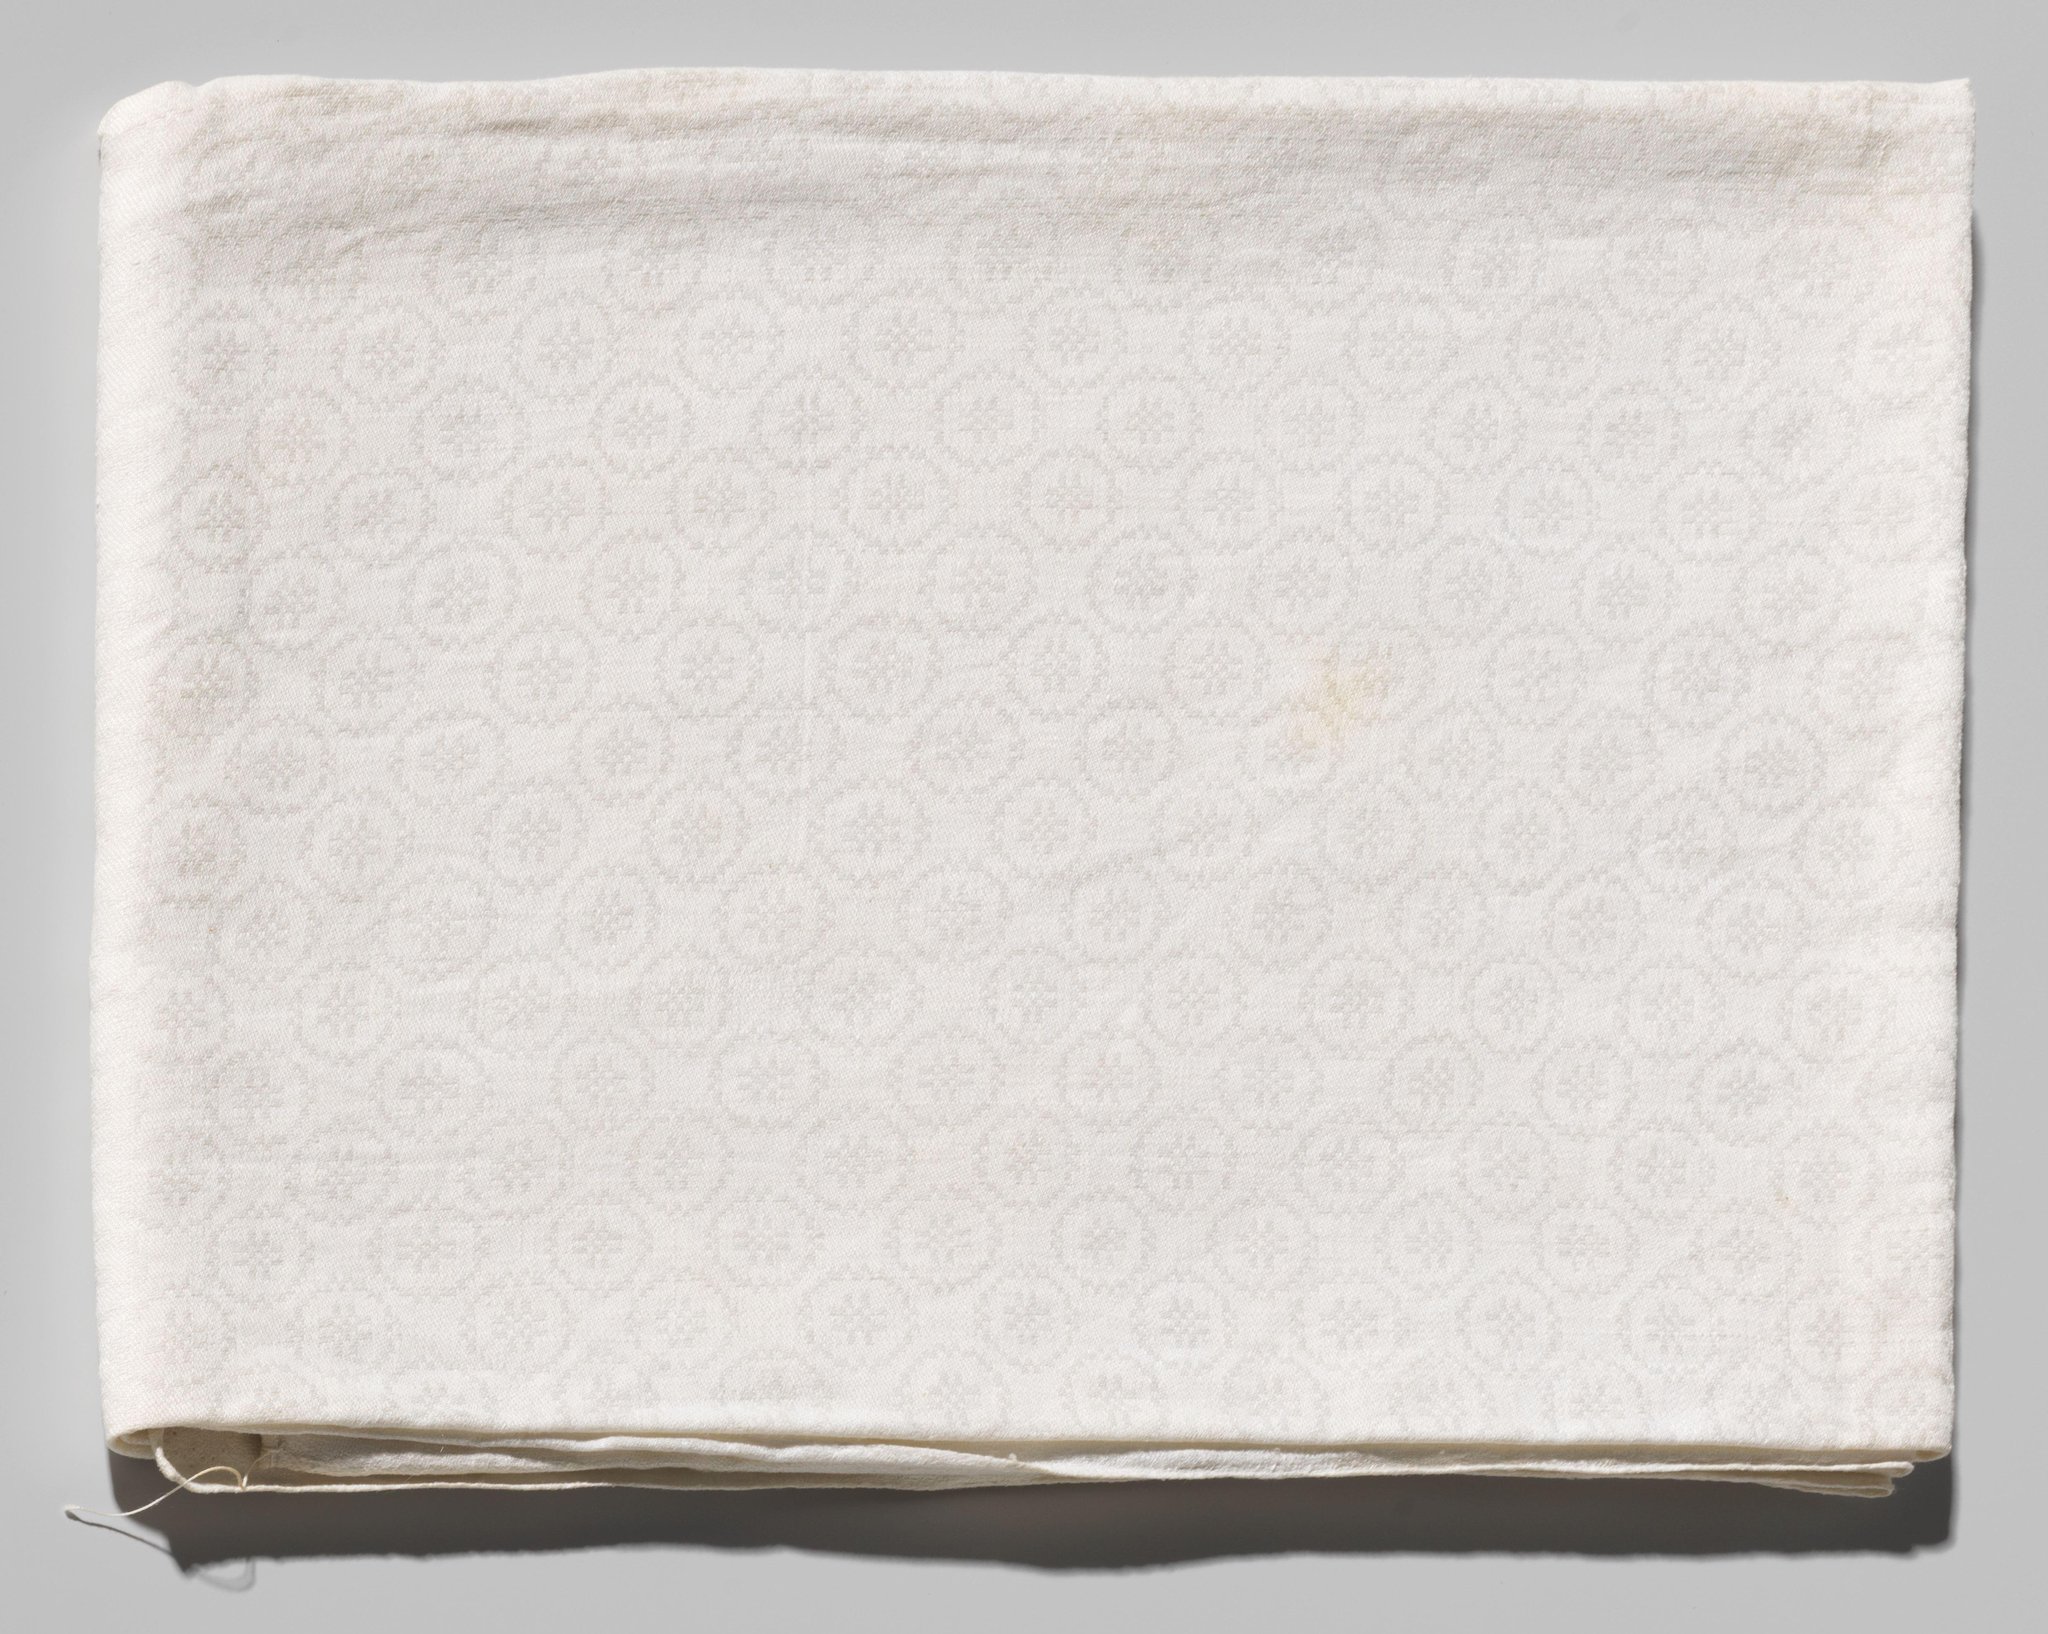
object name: napkin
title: Servet met pellenpatroon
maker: Anonymous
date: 1700-1800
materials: linen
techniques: damask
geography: north brabant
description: Servet van wit linnendamast met pellenpatroon. Oneindig rapport van in verspringende rijen gerangschikte rondjes, waarin verdubbelde kruizen. Gemerkt met open werksteek MI en Ho.